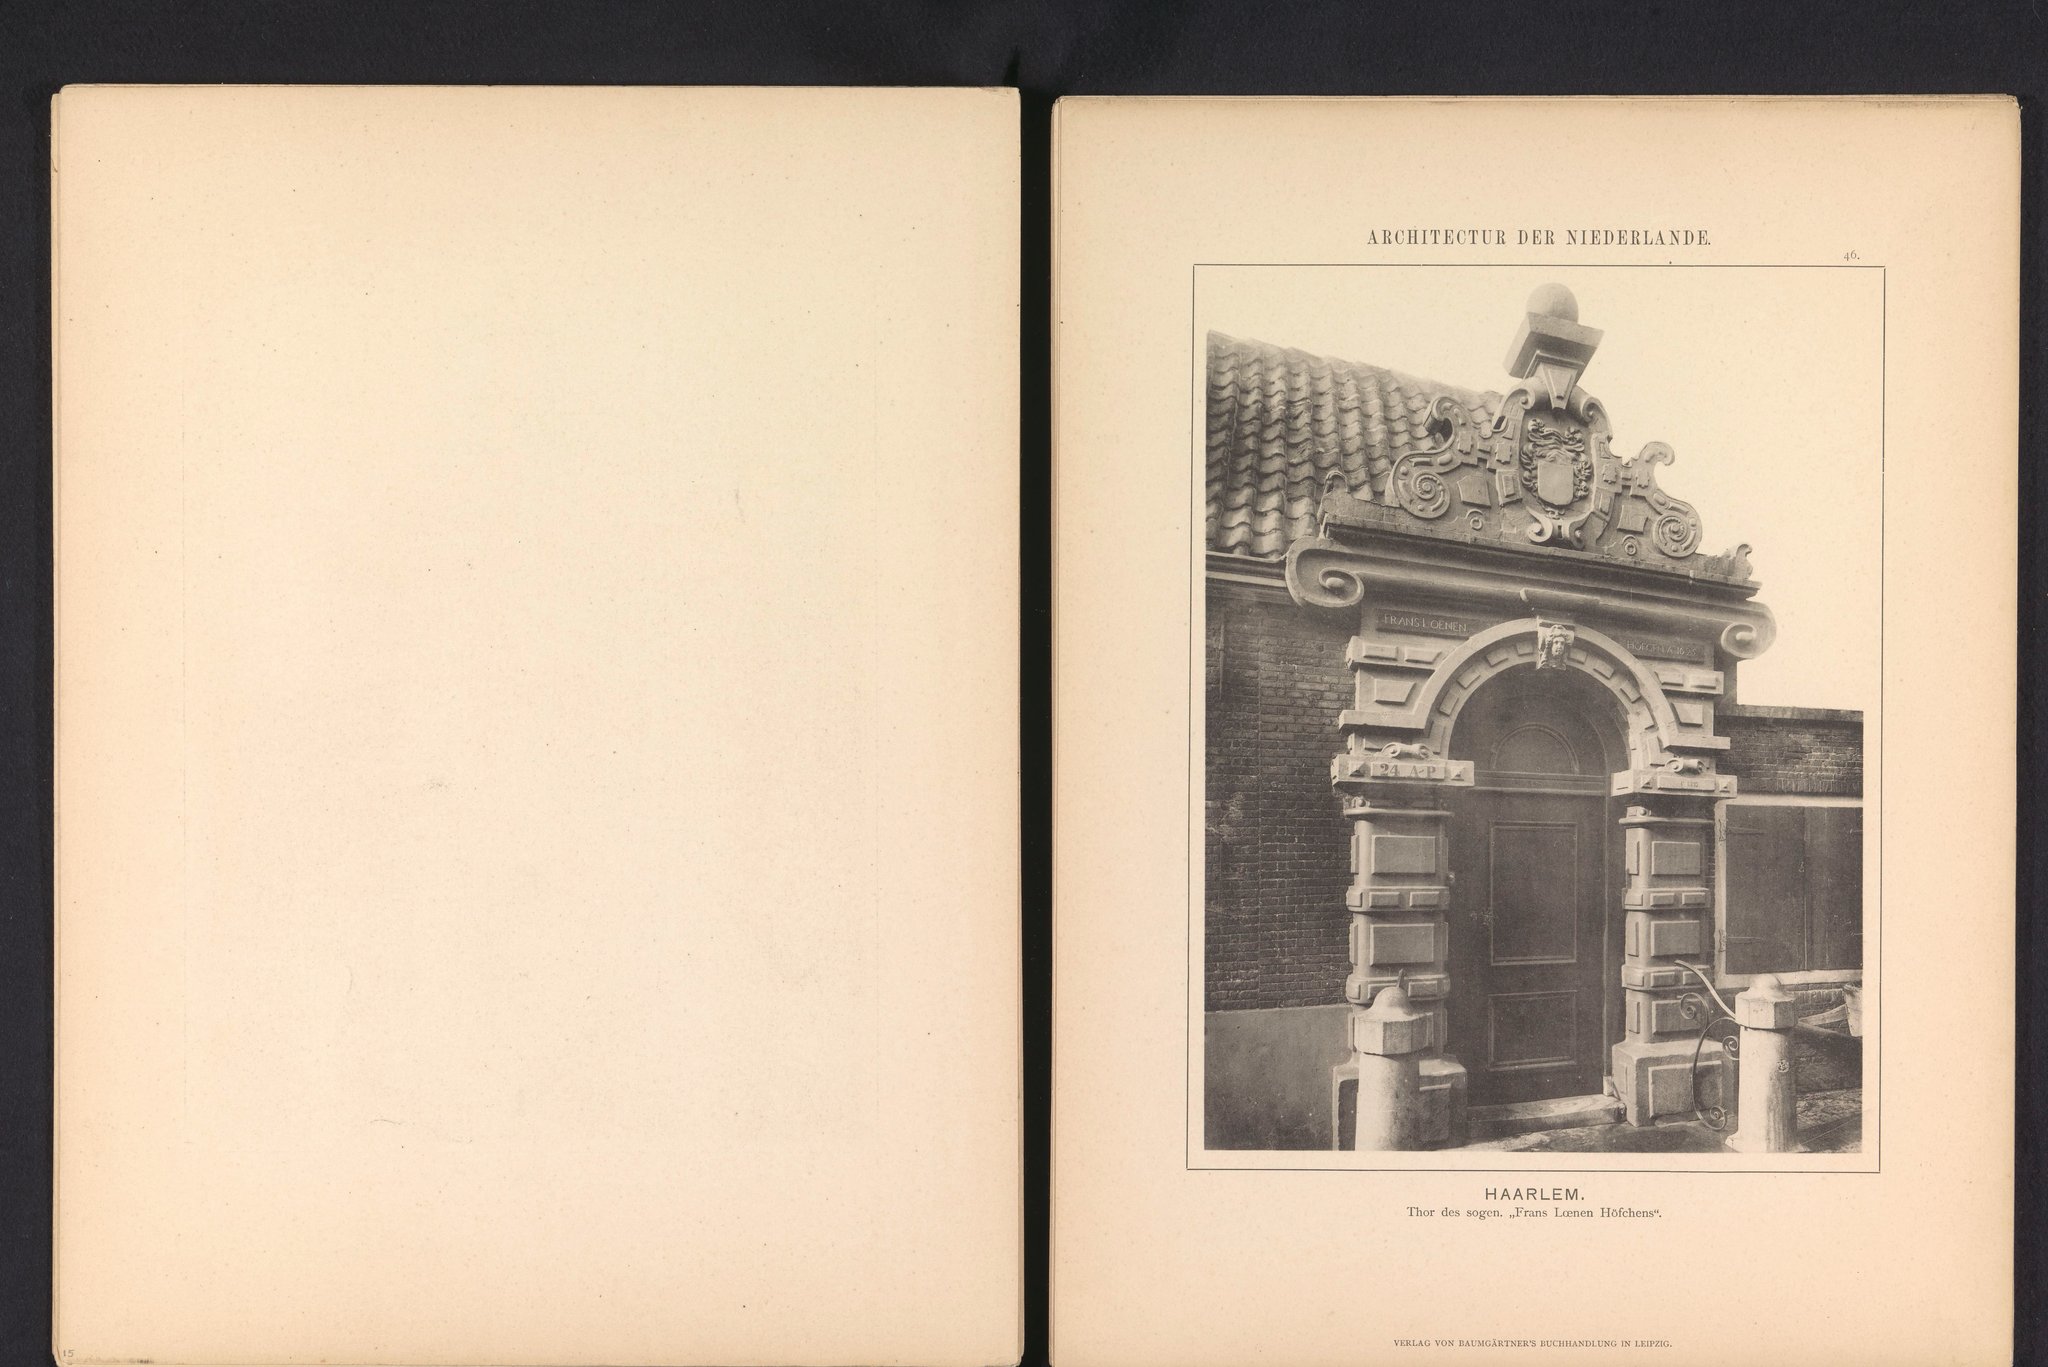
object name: photomechanical print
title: Gezicht op de poort van het Frans Loenenhofje in Haarlem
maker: Anonymous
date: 1884-1894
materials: paper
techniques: photograph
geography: haarlem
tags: alms-house (dutch: 'hofje'), gate, entrance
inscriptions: number: ‘46.’